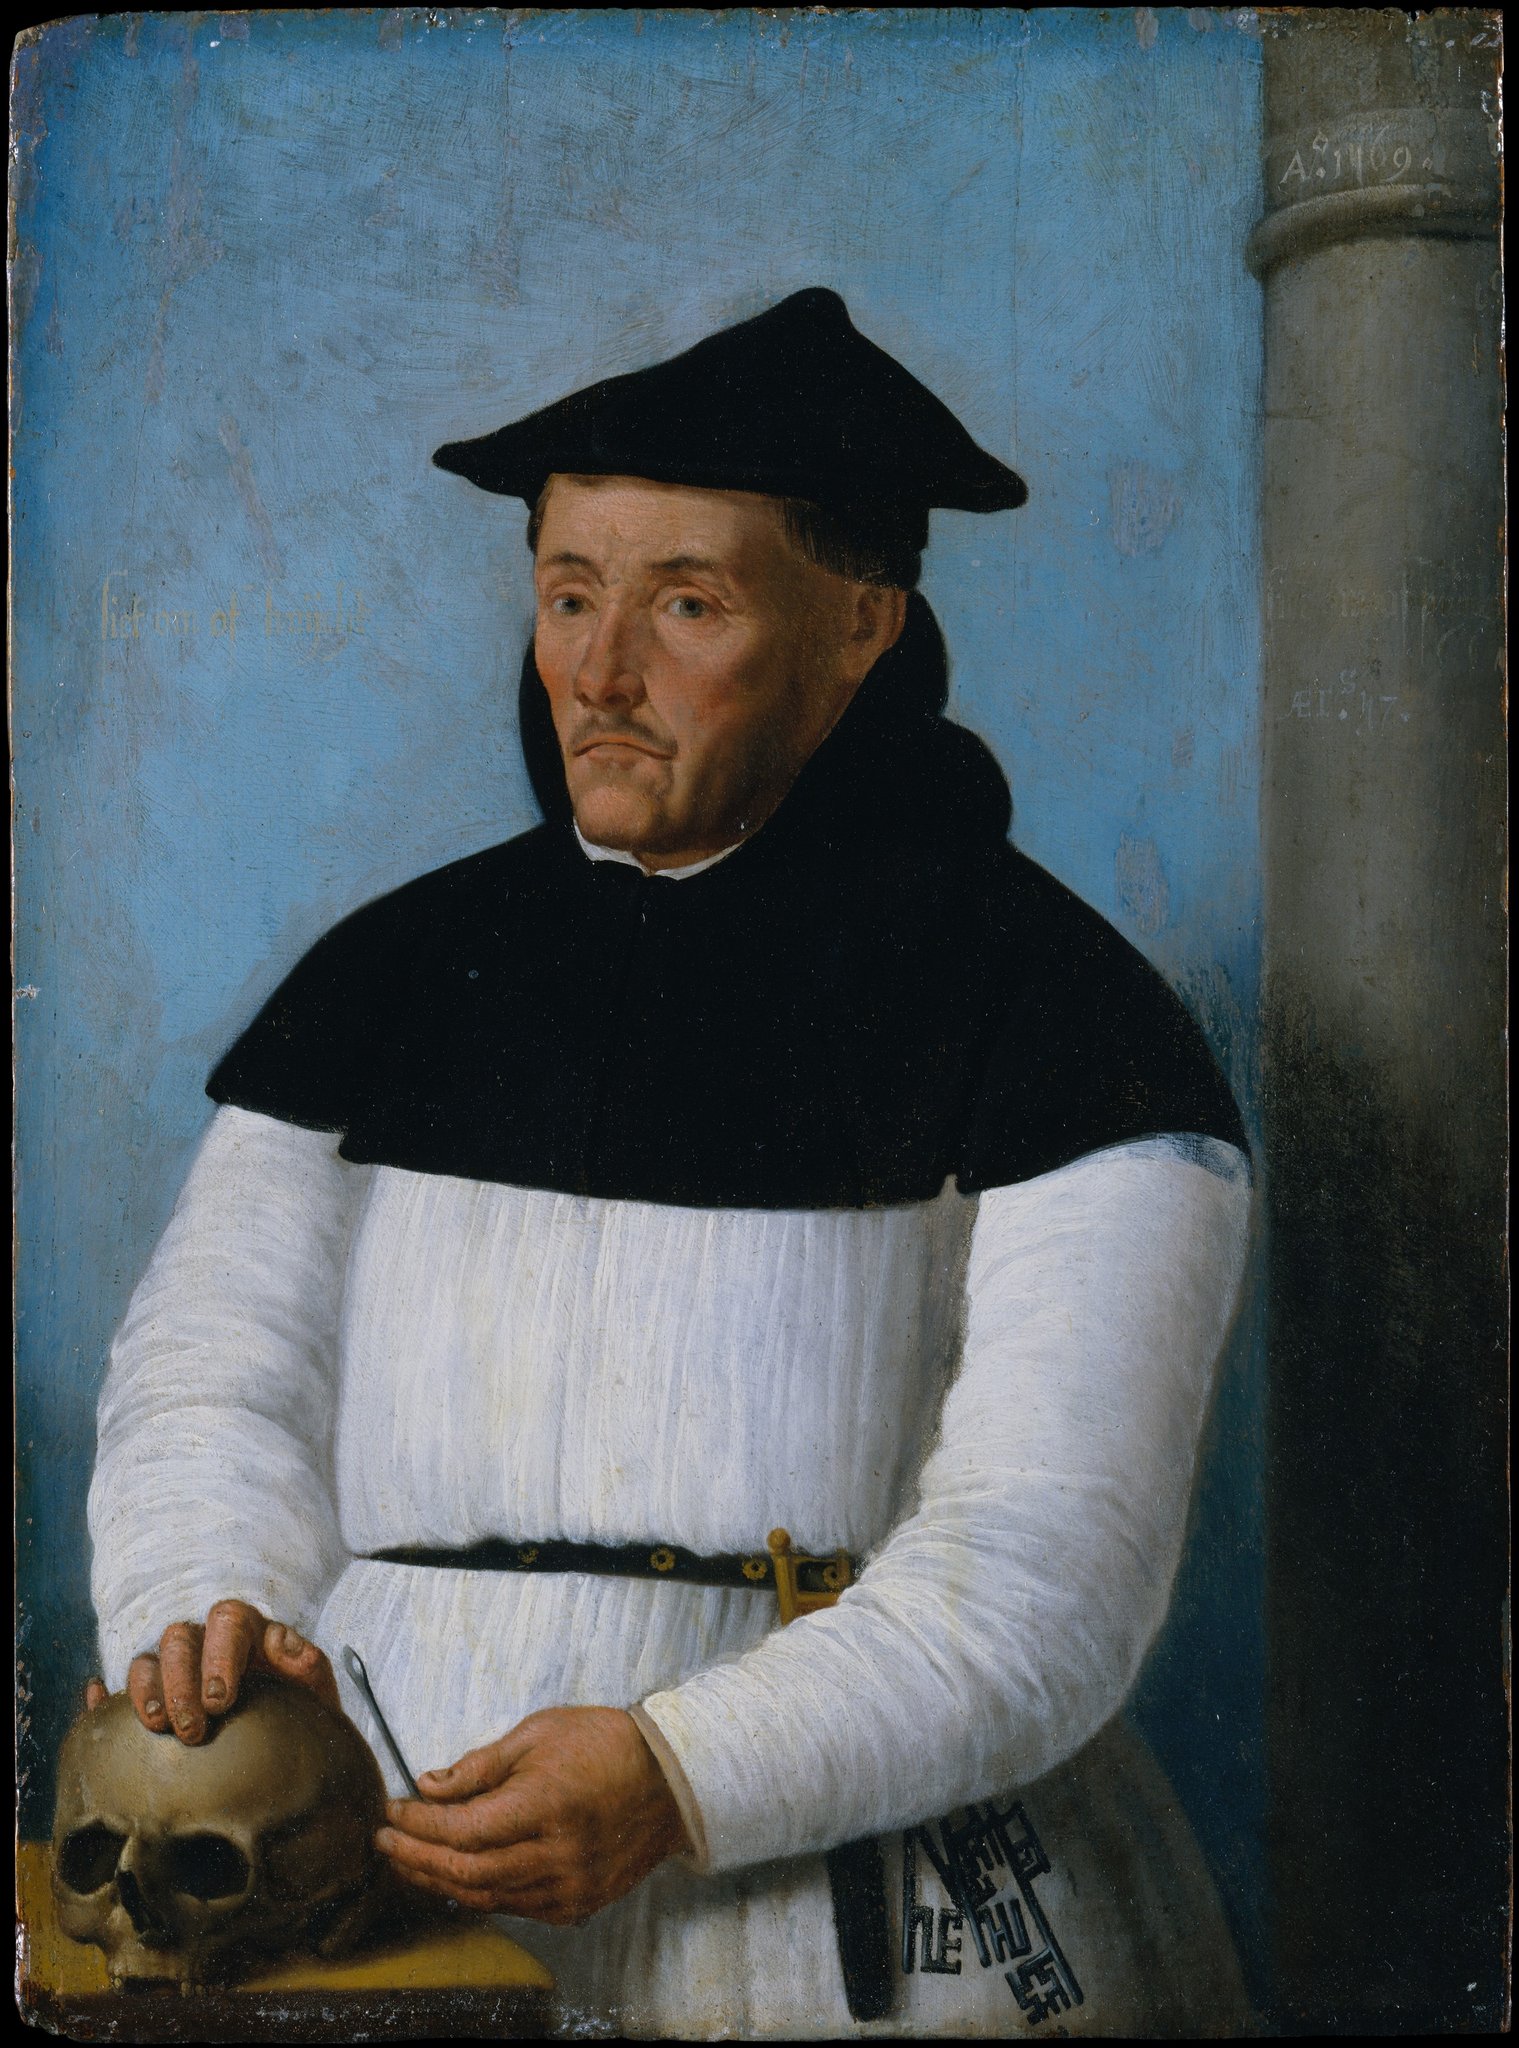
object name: painting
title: Portrait of a Surgeon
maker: netherlandish painter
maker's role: artist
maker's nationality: netherlandish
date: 1569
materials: oil, wood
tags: men,portraits,doctors